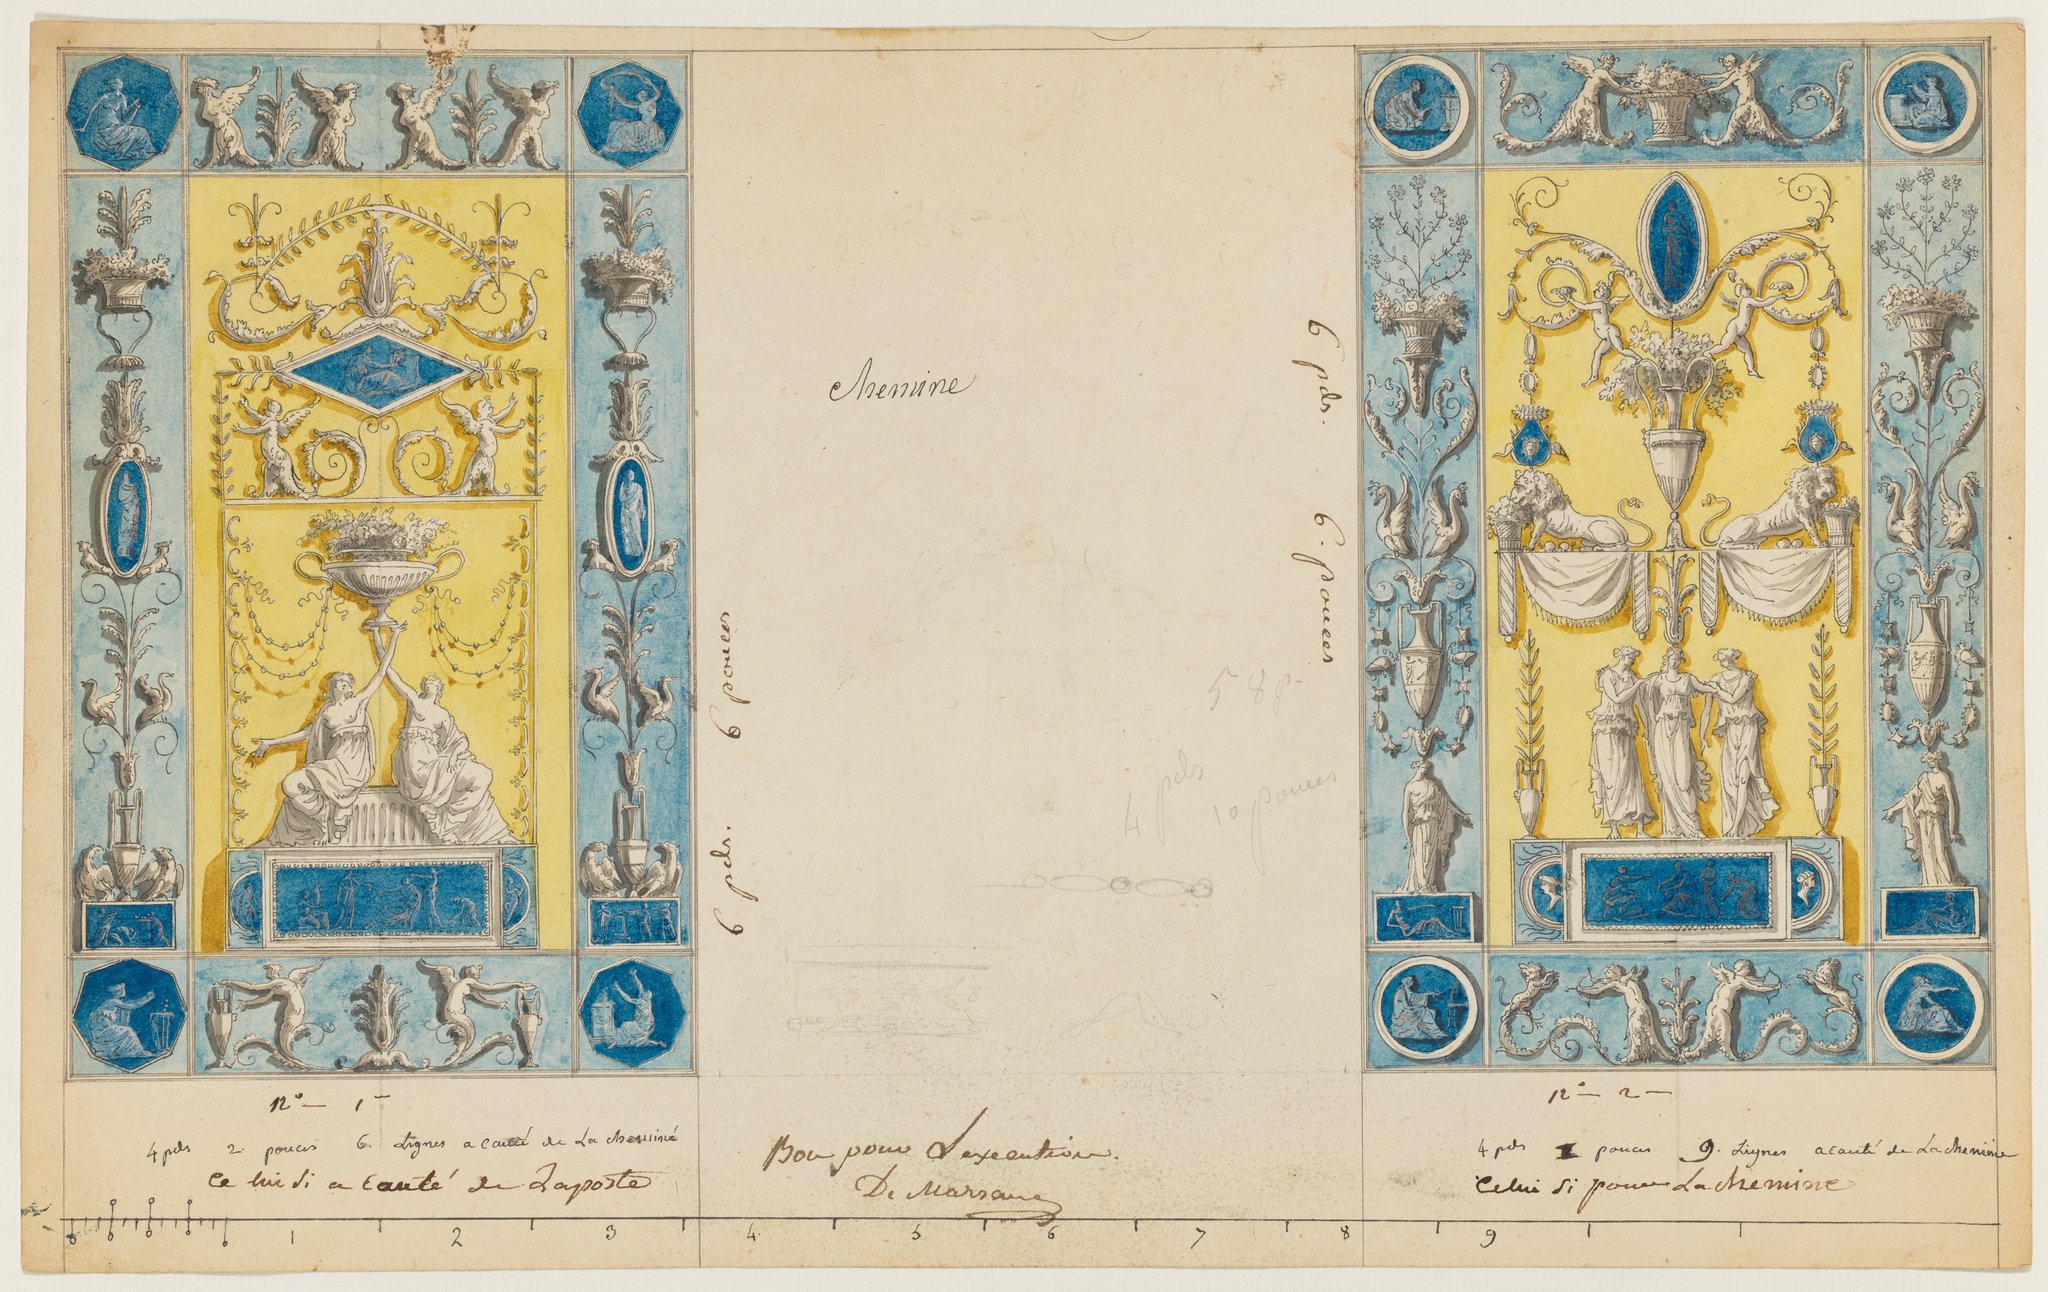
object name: album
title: Designs for wall panels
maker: anonymous, french, 19th century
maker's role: artist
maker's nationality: french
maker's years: 1800-1900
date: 1801-1833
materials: ink, watercolor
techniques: pen